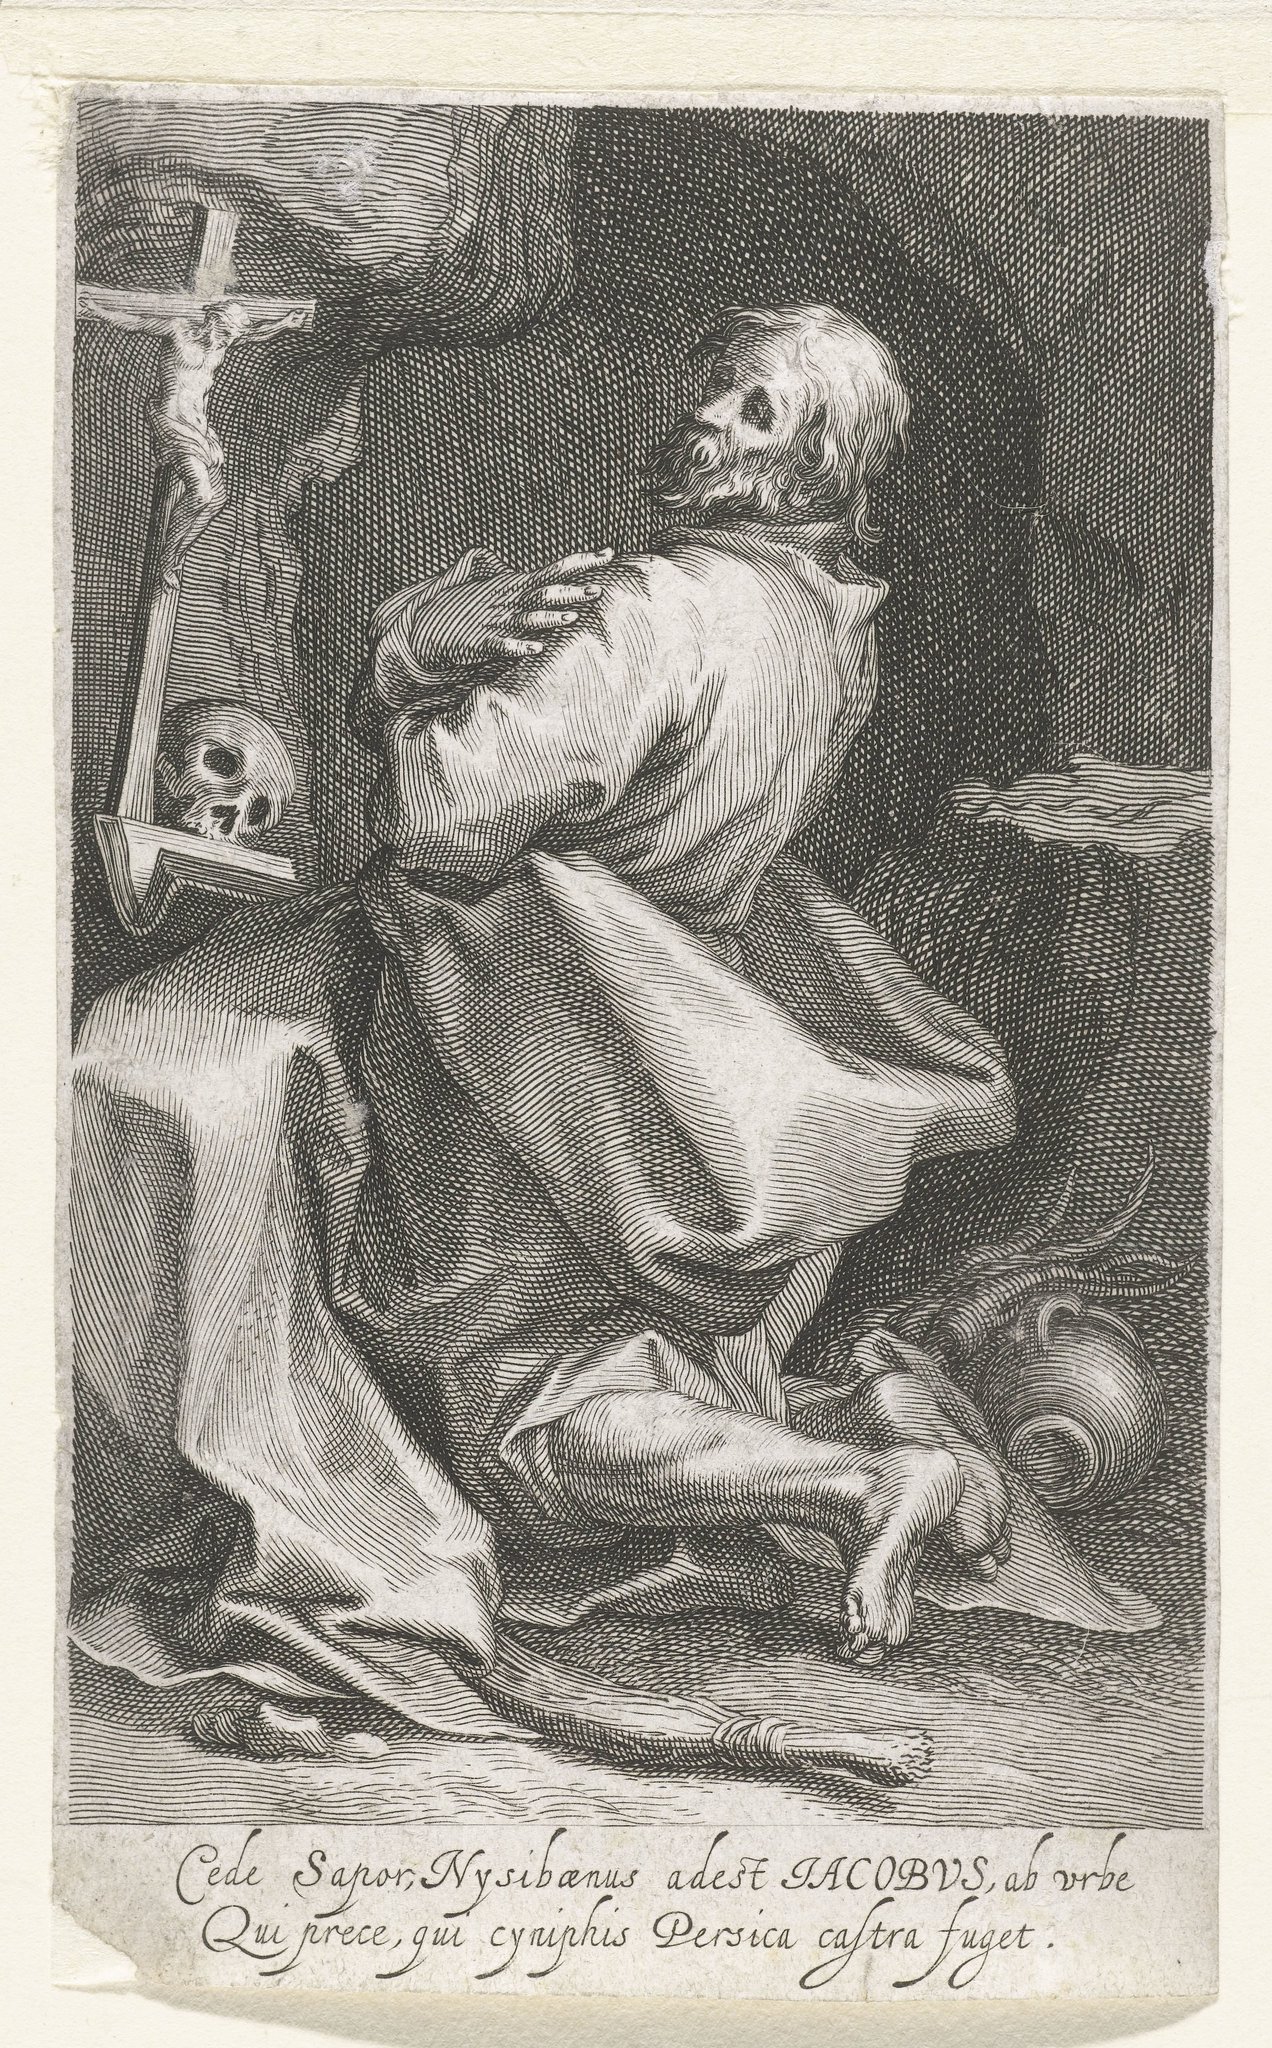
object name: book illustration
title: Cede sapor Nysibaenus (...) Persica castra fuget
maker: boëtius adamsz. bolswert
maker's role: print maker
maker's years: 1580-1633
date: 1590-1612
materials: paper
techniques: engraving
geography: low countries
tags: saints, anchorite, hermit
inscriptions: collector's mark: Lugt 2228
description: Prent uit: Ad sacrum speculum recurris? ... patribus dat ales, geen plaats, Boëtius Adamsz. Bolswert, 1612. Tweede ongebonden uitgave met in totaal vijftig prenten. Prent uit serie van drieentwintig mannelijke kluizenaars. In 1619 verscheen een gebonden editie maar op basis van de gewijzigde opschriften en samenstelling wordt aangenomen dat deze prenten ook in 1612 of iets daarvoor gedrukt werden. Roethlisberger beschouwt de uitgave van 1619 als de eerste staat en de ongebonden editie van 1612 als de tweede staat (Roethlisberger 1993, p. 171, 172). Op de prent is het opschrift met de naam van de heilige gewijzigd, volgens het opschrift bij de eerste staat is de heilige Macarius van Alexandrië weergegeven.